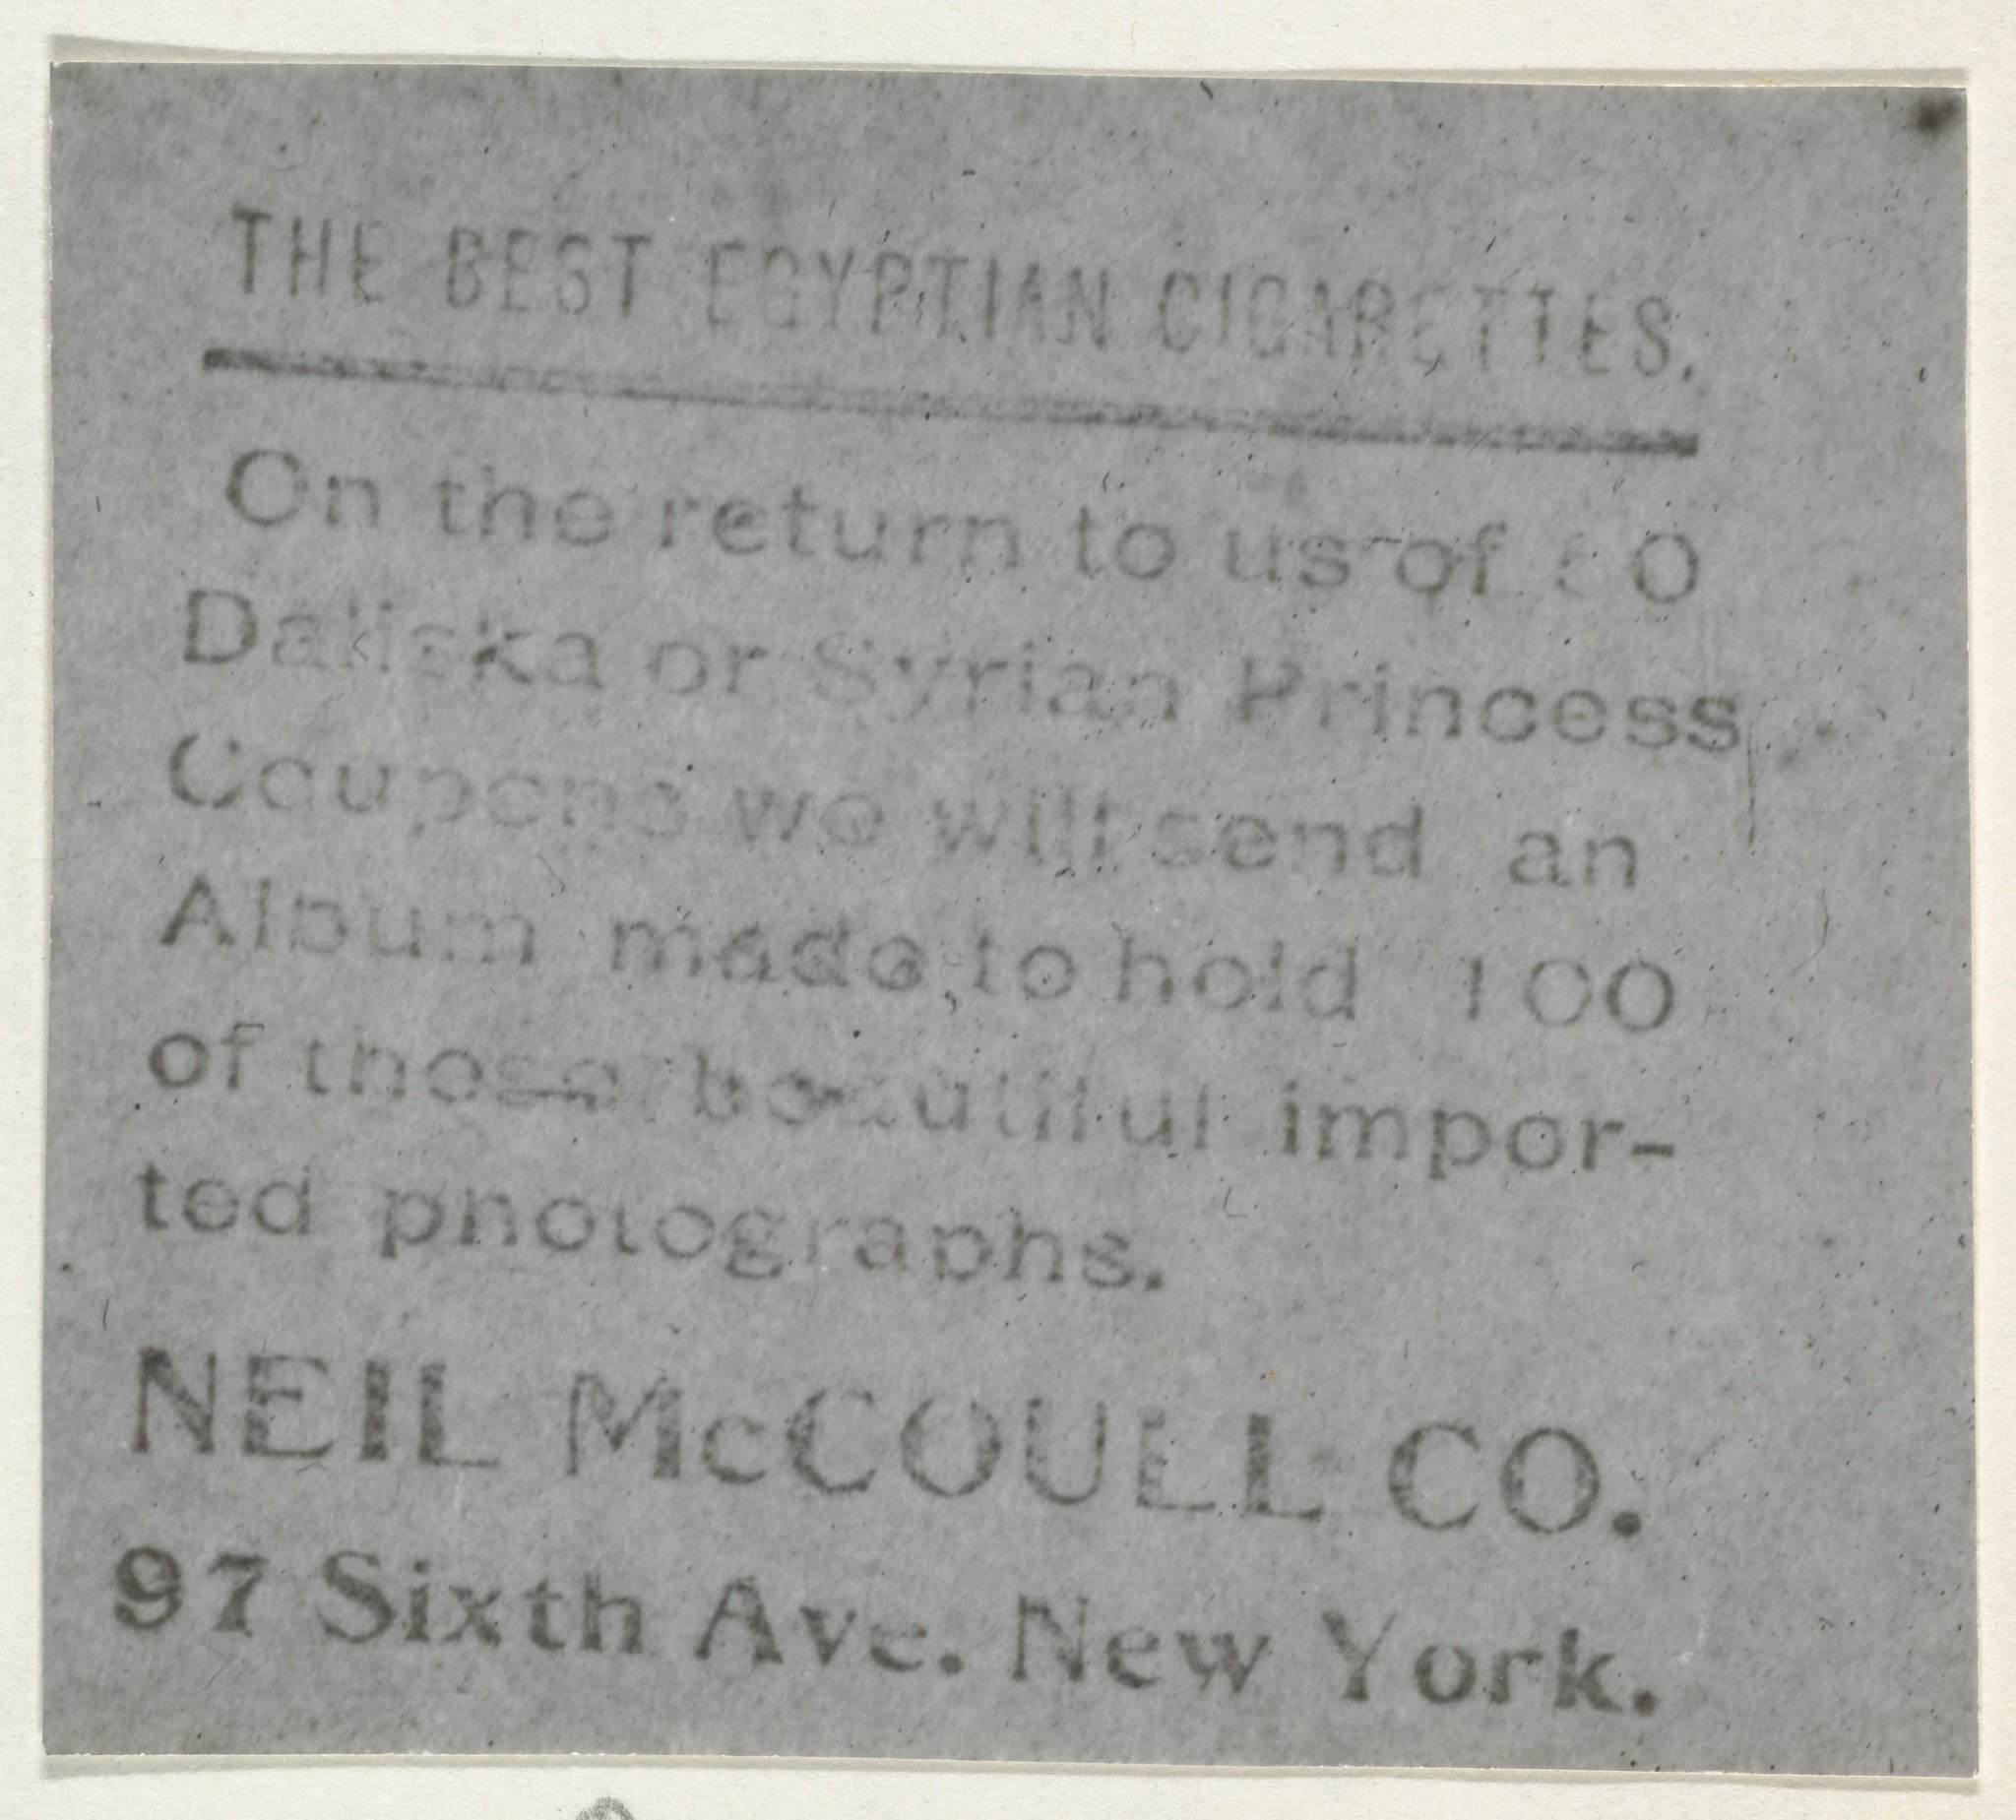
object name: print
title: Facsimile of card verso, from the Actresses series (T123, Type 1), issued by Neil McCoull Co.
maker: neil mccoull co.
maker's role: publisher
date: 1897